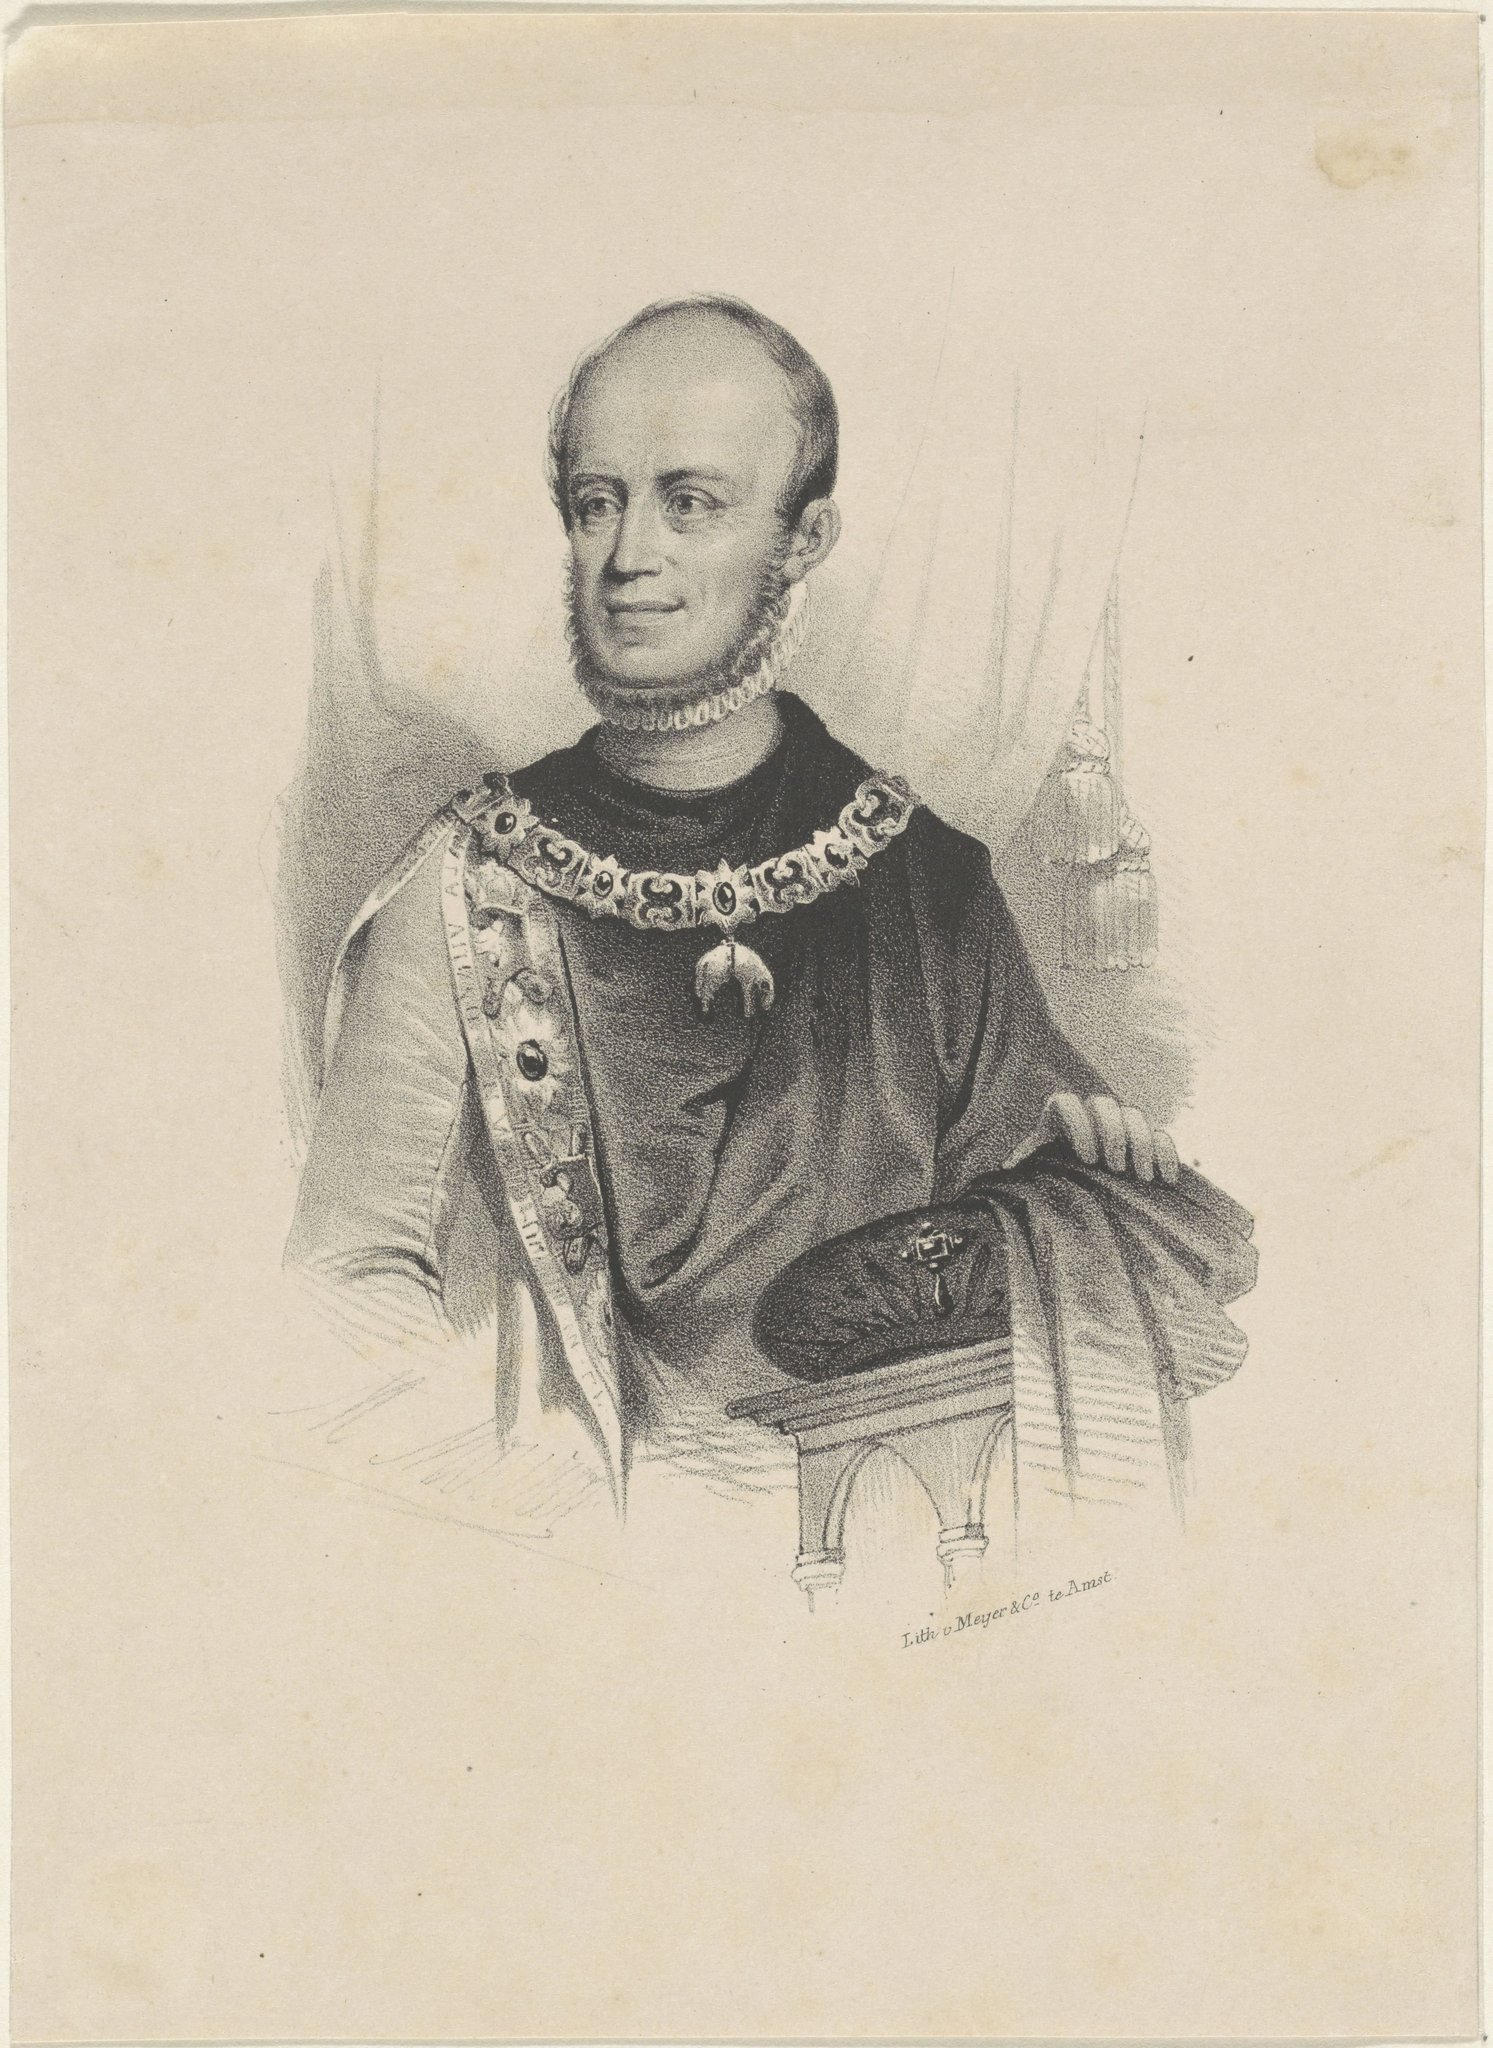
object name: print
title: Portret van Willem II, koning der Nederlanden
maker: michel mourot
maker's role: draughtsman, print maker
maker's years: 1803-1847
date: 1818-1847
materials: paper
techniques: lithograph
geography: netherlands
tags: the hague, william ii of the netherlands, knighthood order of the golden fleece - insignia of a knighthood order, e.g.: badge, chain (with name of order)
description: De hier vermelde titel verwijst naar de hoogst verkregen titel van de geportretteerde, niet per se naar de titel die de geportretteerde op deze voorstelling draagt.